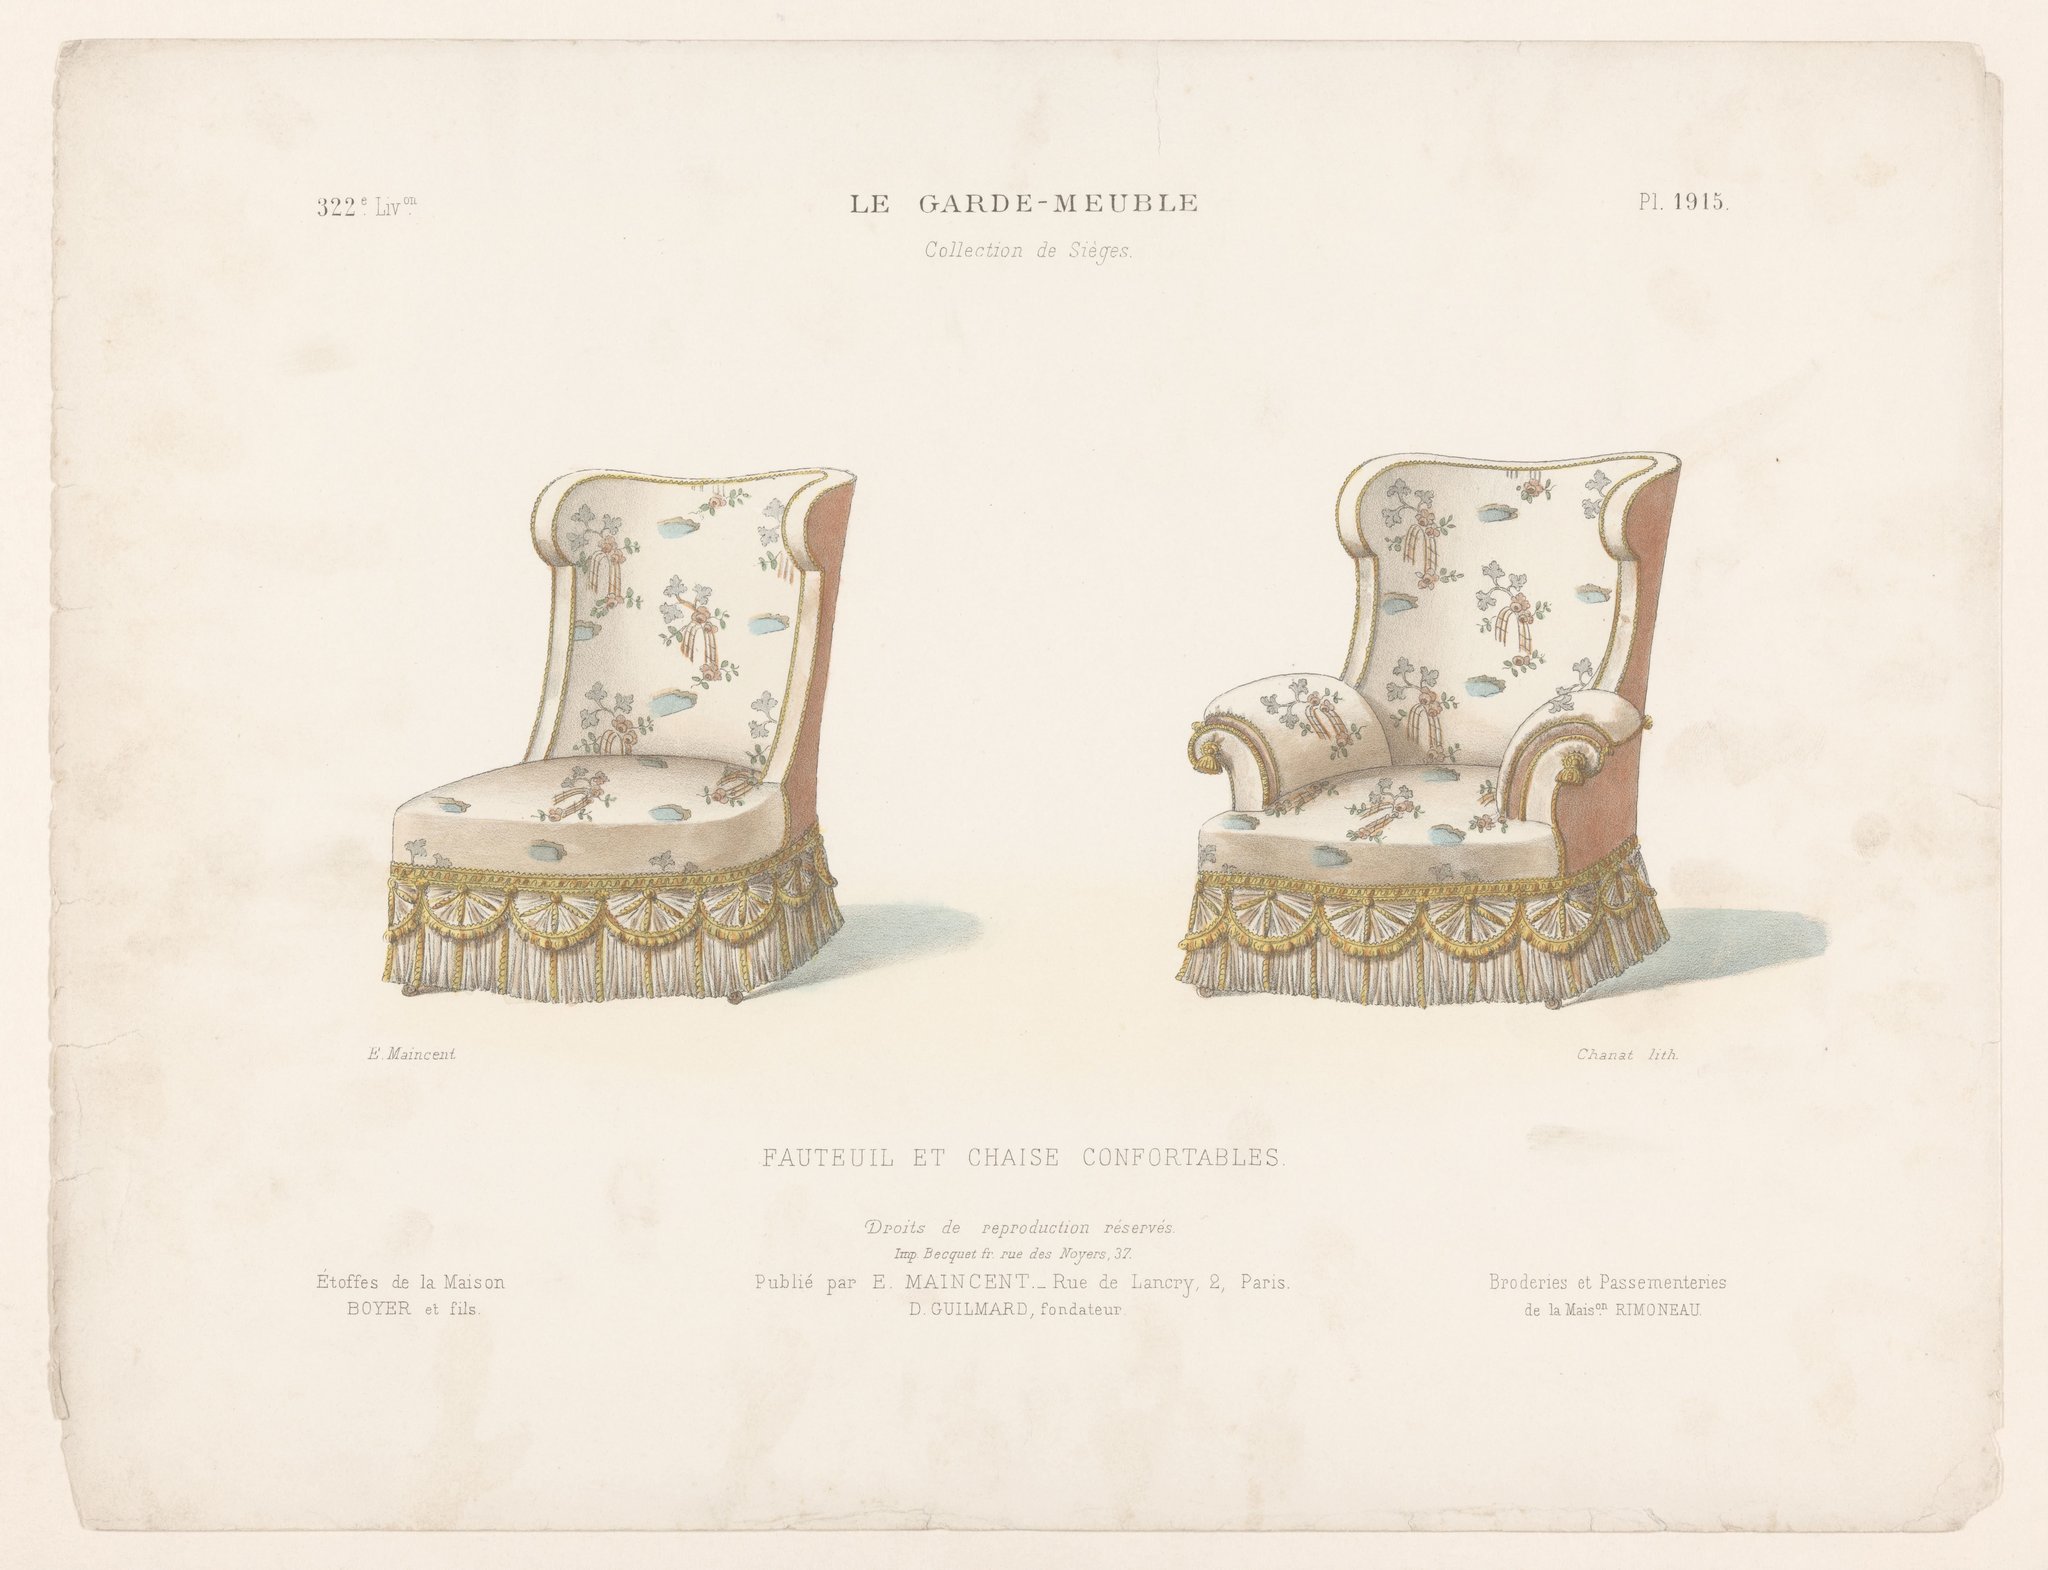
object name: print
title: Le garde-meuble / Collection de Sièges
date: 1885-1895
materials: paper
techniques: hand coloring, lithograph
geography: paris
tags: seating furniture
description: Ieder Livraison in de serie Le Garde-Meuble bevat negen platen: drie 'sièges' (zitmeubels), drie 'meubles' (diverse meubels zoals tafels en kasten) en drie 'tentures' (gordijnen en draperieën).